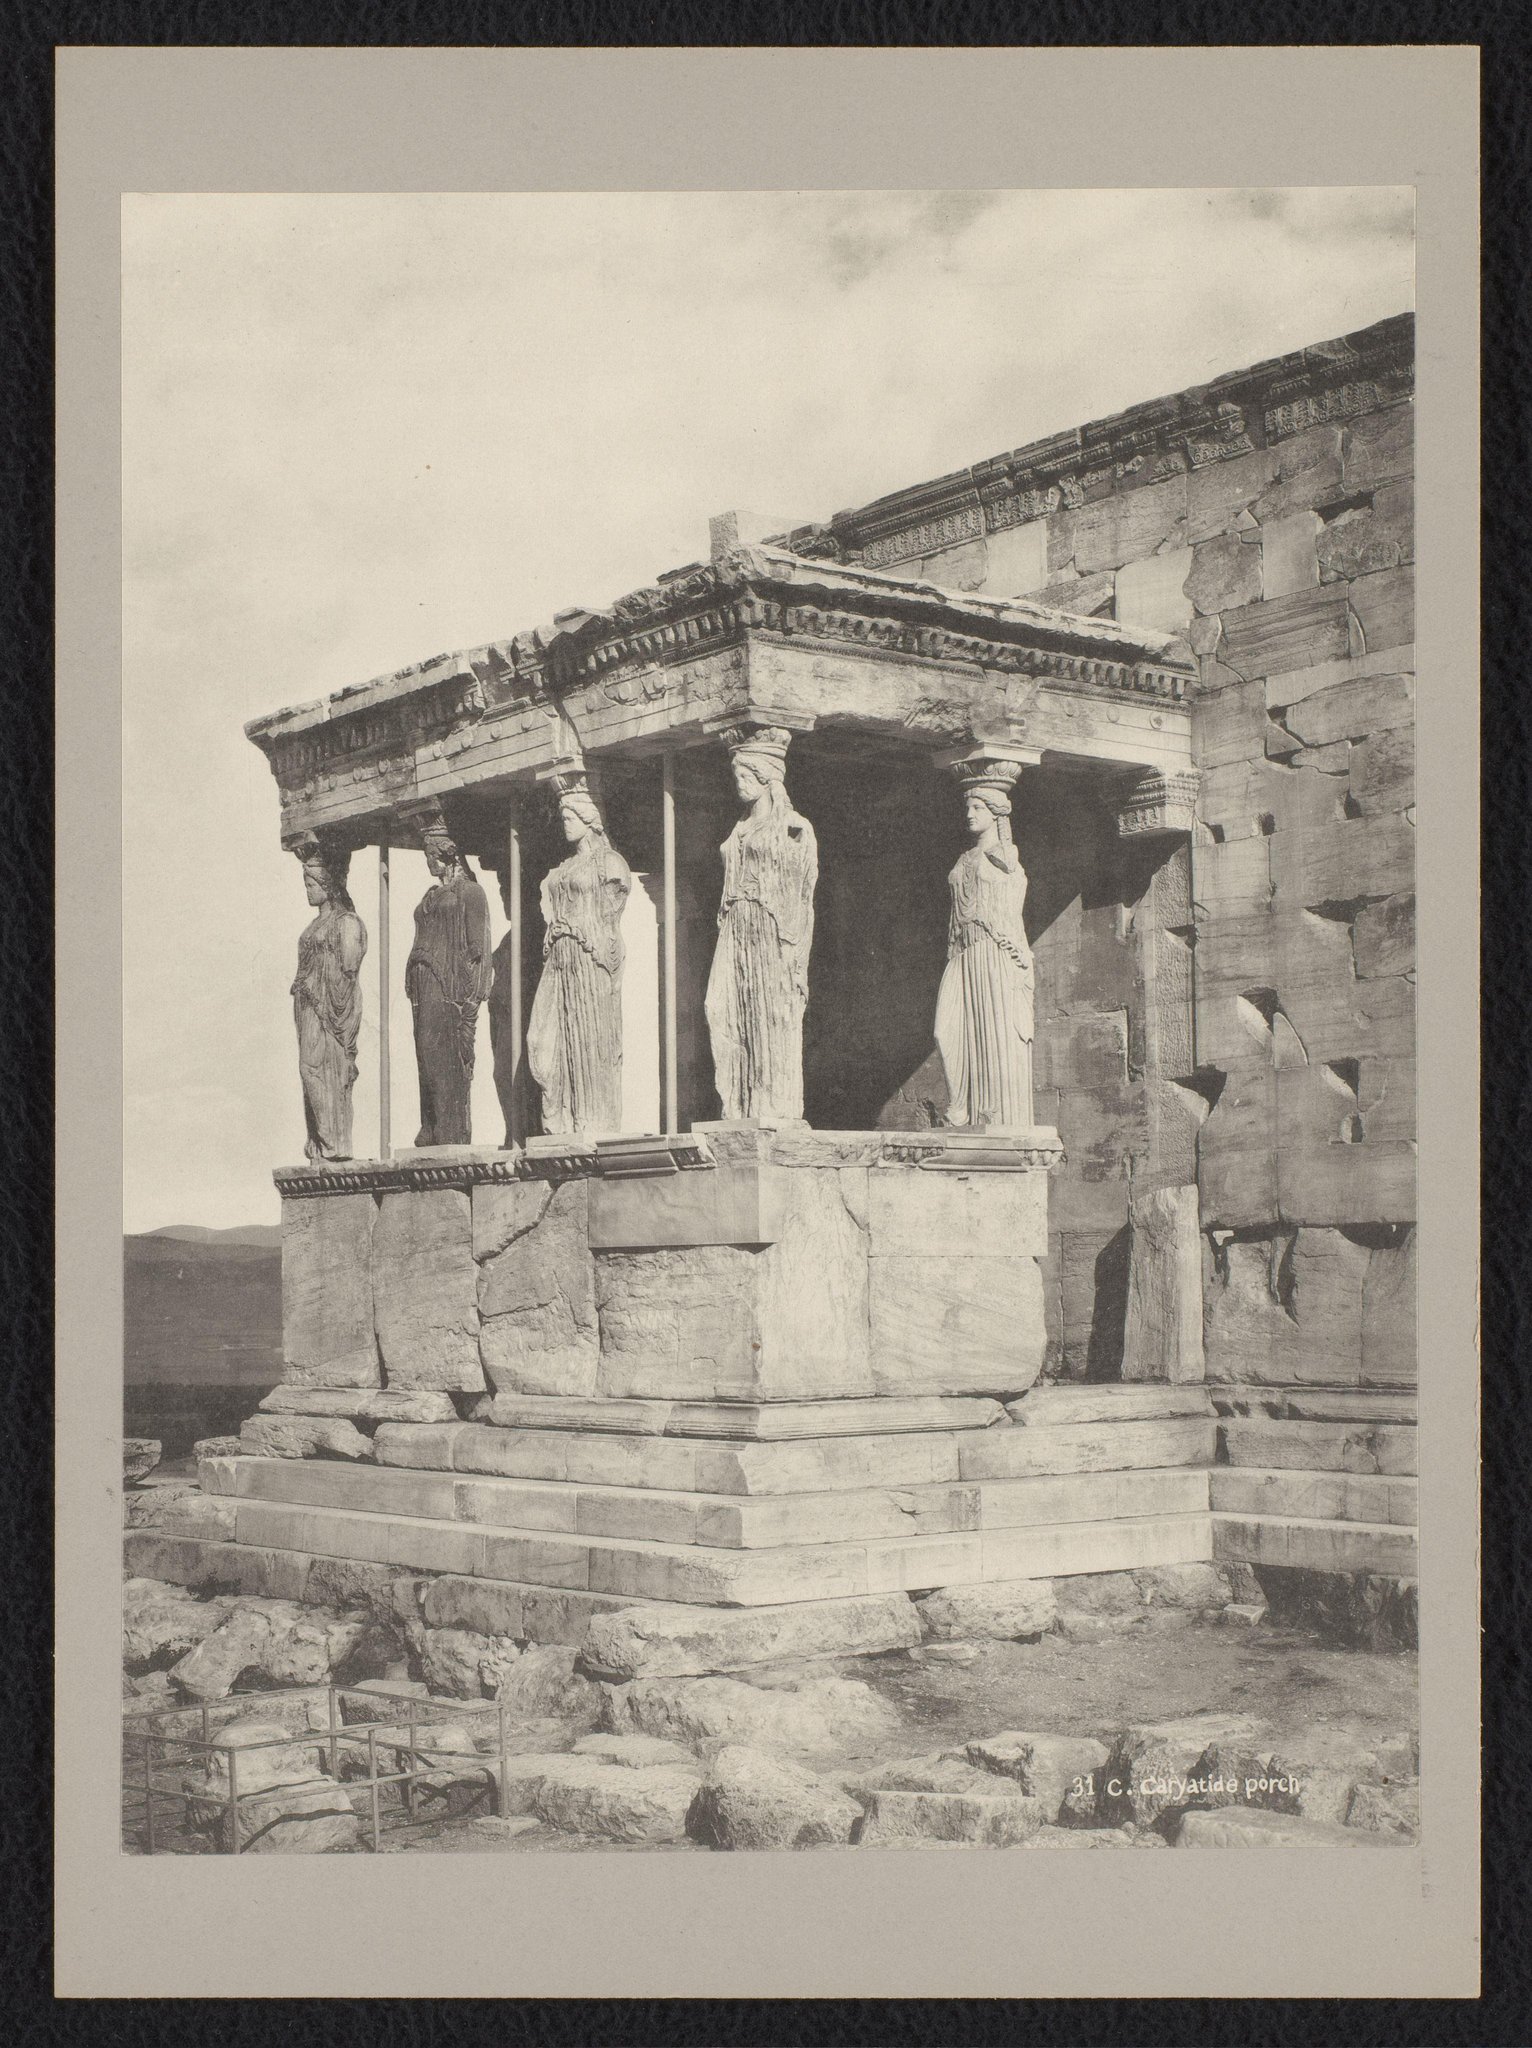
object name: photograph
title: Gezicht op de Kariatiden bij het Erechtheion op de Akropolis in Athene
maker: Anonymous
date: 1895-1915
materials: cardboard, paper, photographic support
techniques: photograph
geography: athens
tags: akropolis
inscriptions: number: ‘27.’, title: ‘31 c. Caryatide porch’